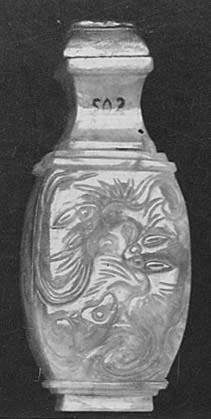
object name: snuff bottle with stopper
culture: chinese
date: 1736-1795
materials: jade